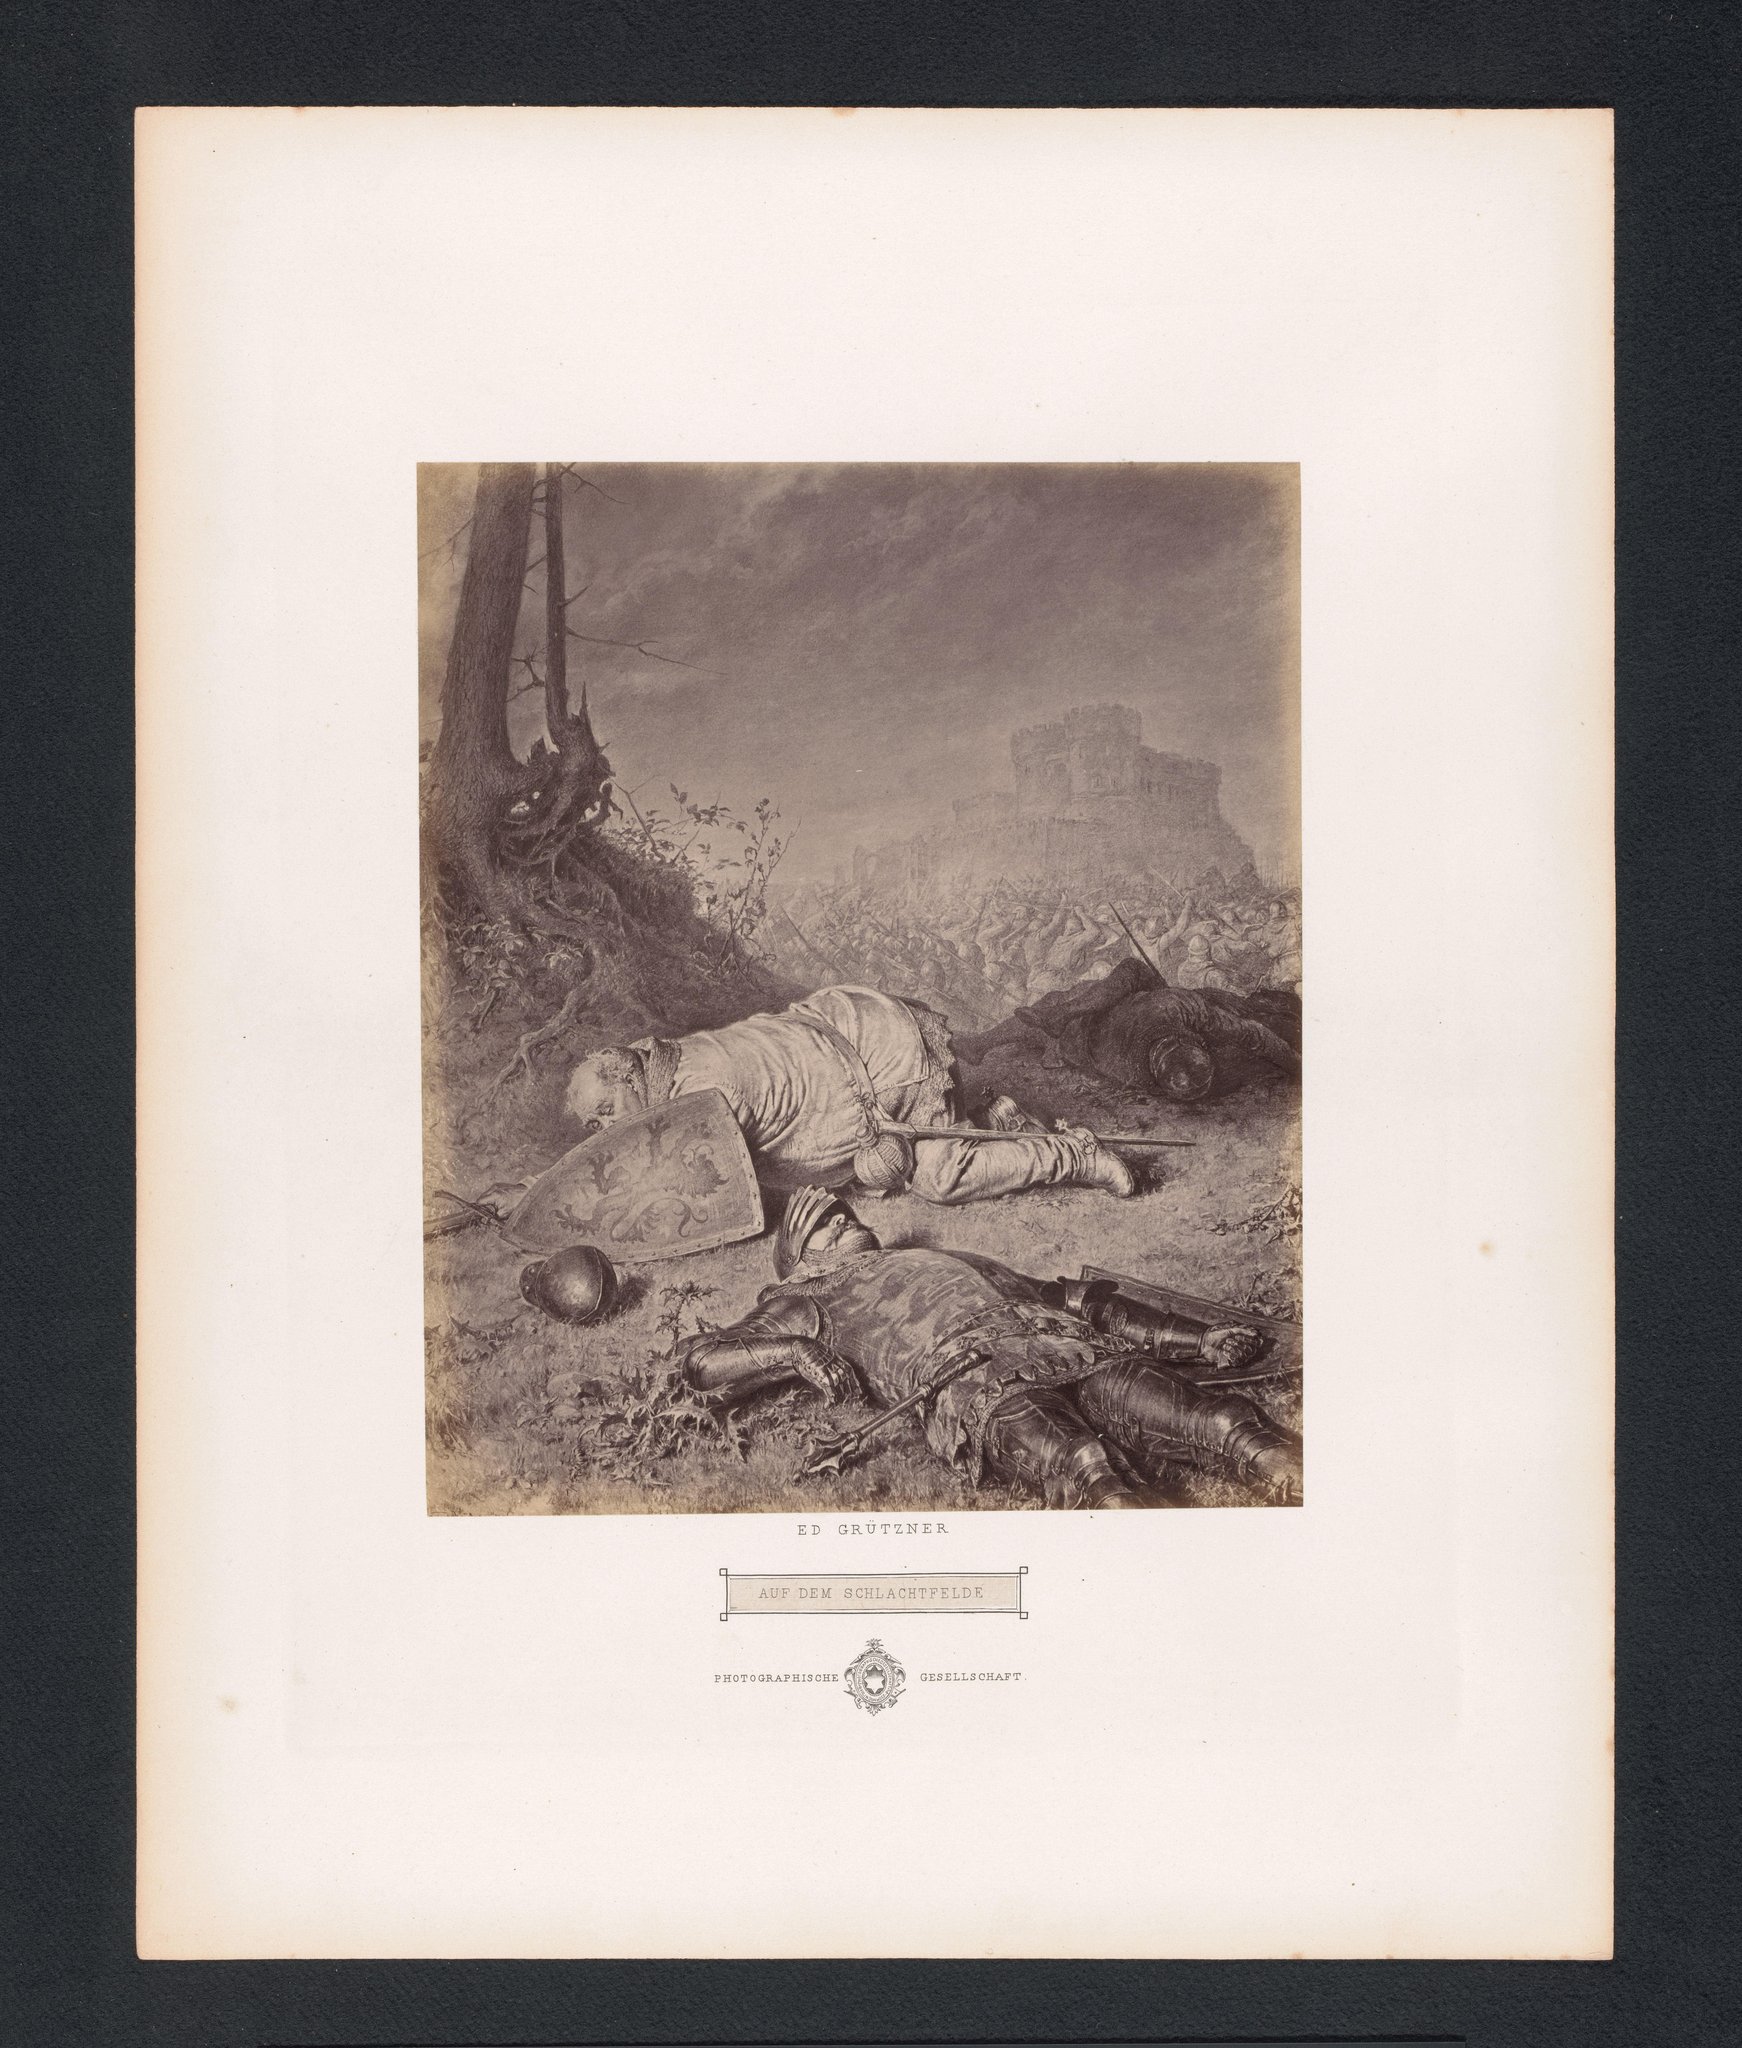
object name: photograph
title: Auf dem Schlachtfelde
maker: eduard von grützner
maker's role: painter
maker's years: 1846-1925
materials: photographic support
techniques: albumen print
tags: the defeated (after the battle), specific works of literature, falstaff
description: Deze foto maakt deel uit van een omslag met zeven foto's, een titelblad met foto en een tekstblad.